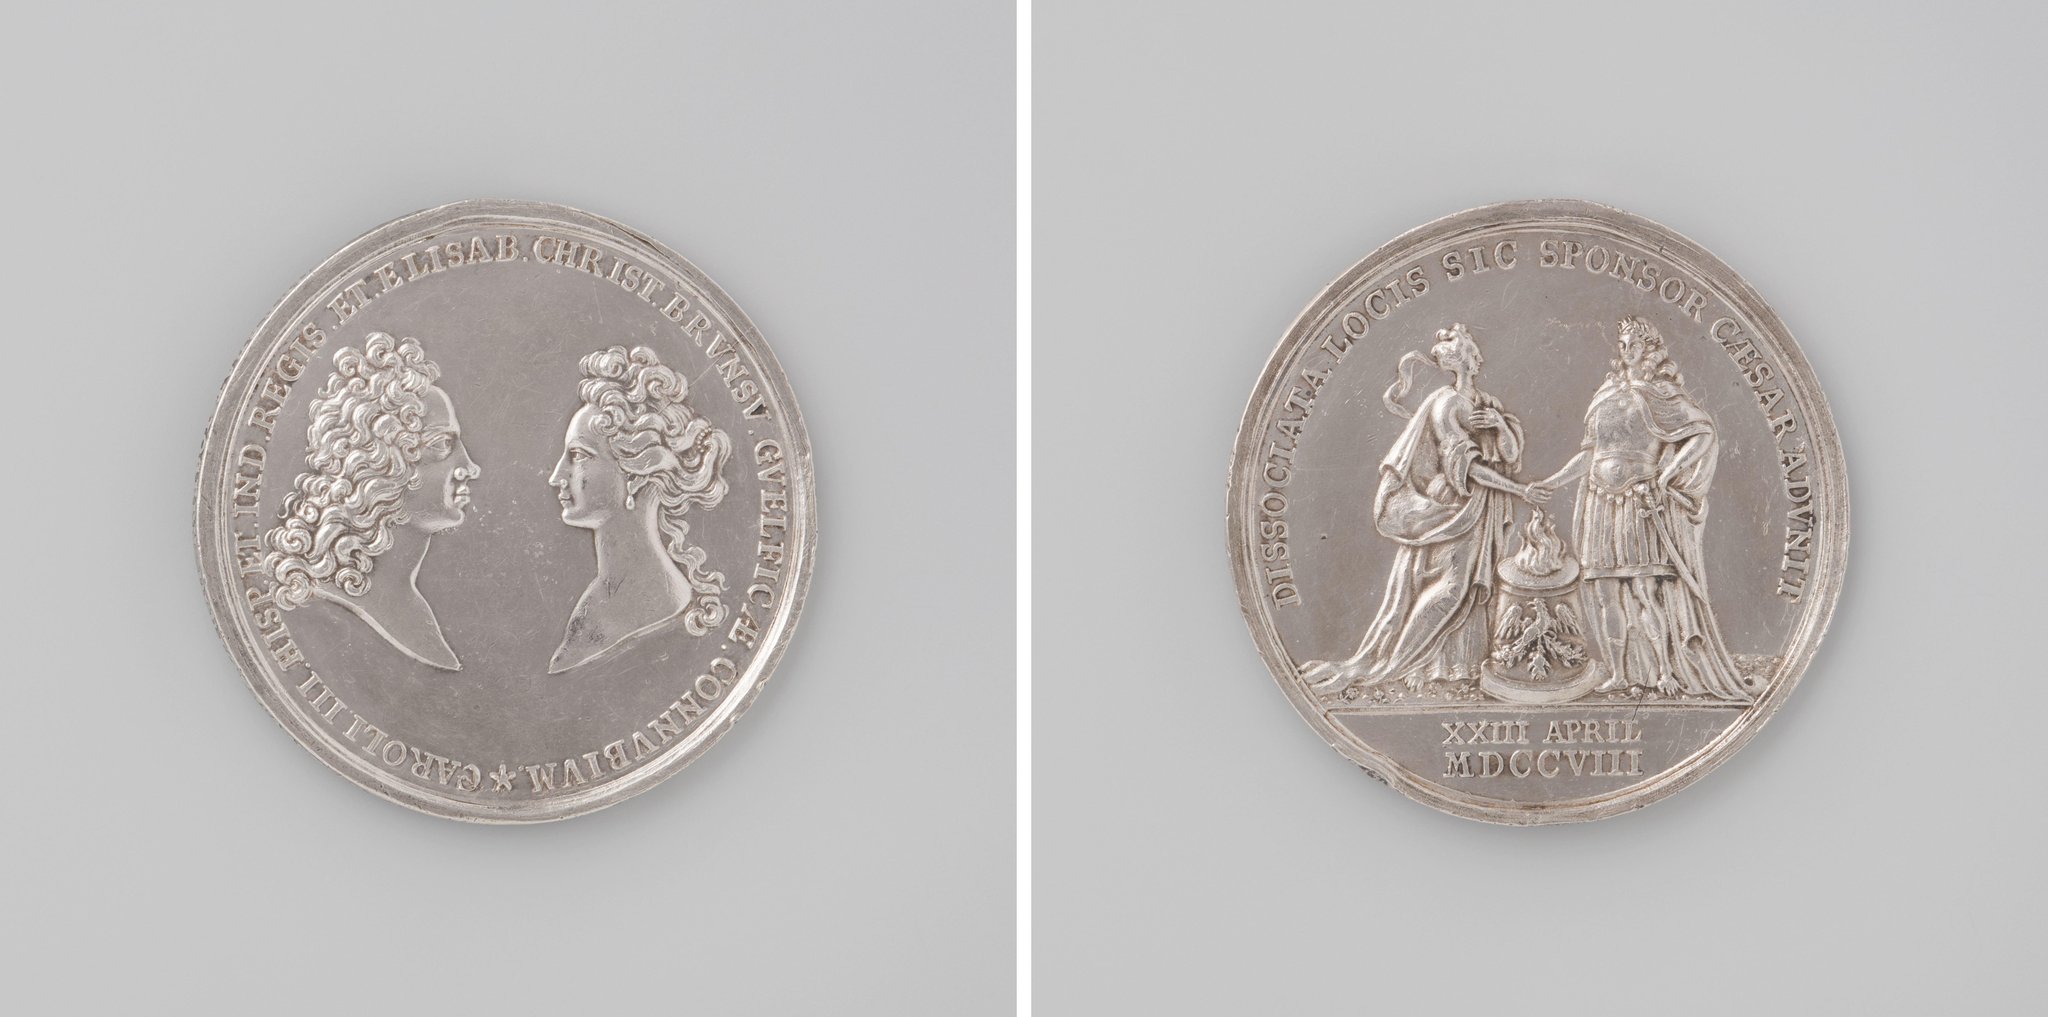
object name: history medal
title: Huwelijk van Karel III van Spanje met Elisabeth Christine van Brunswijk-Wolfenbüttel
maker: Anonymous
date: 1708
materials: silver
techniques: striking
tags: vienna, charles vi (holy roman emperor)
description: Zilveren penning. Voorzijde: borststuk man en vrouw naar elkaar toegekeerd binnen omschrift. Keerzijde: Karel geeft zijn bruid hand boven ontstoken altaar binnen omschrift; afsnede: jaartal